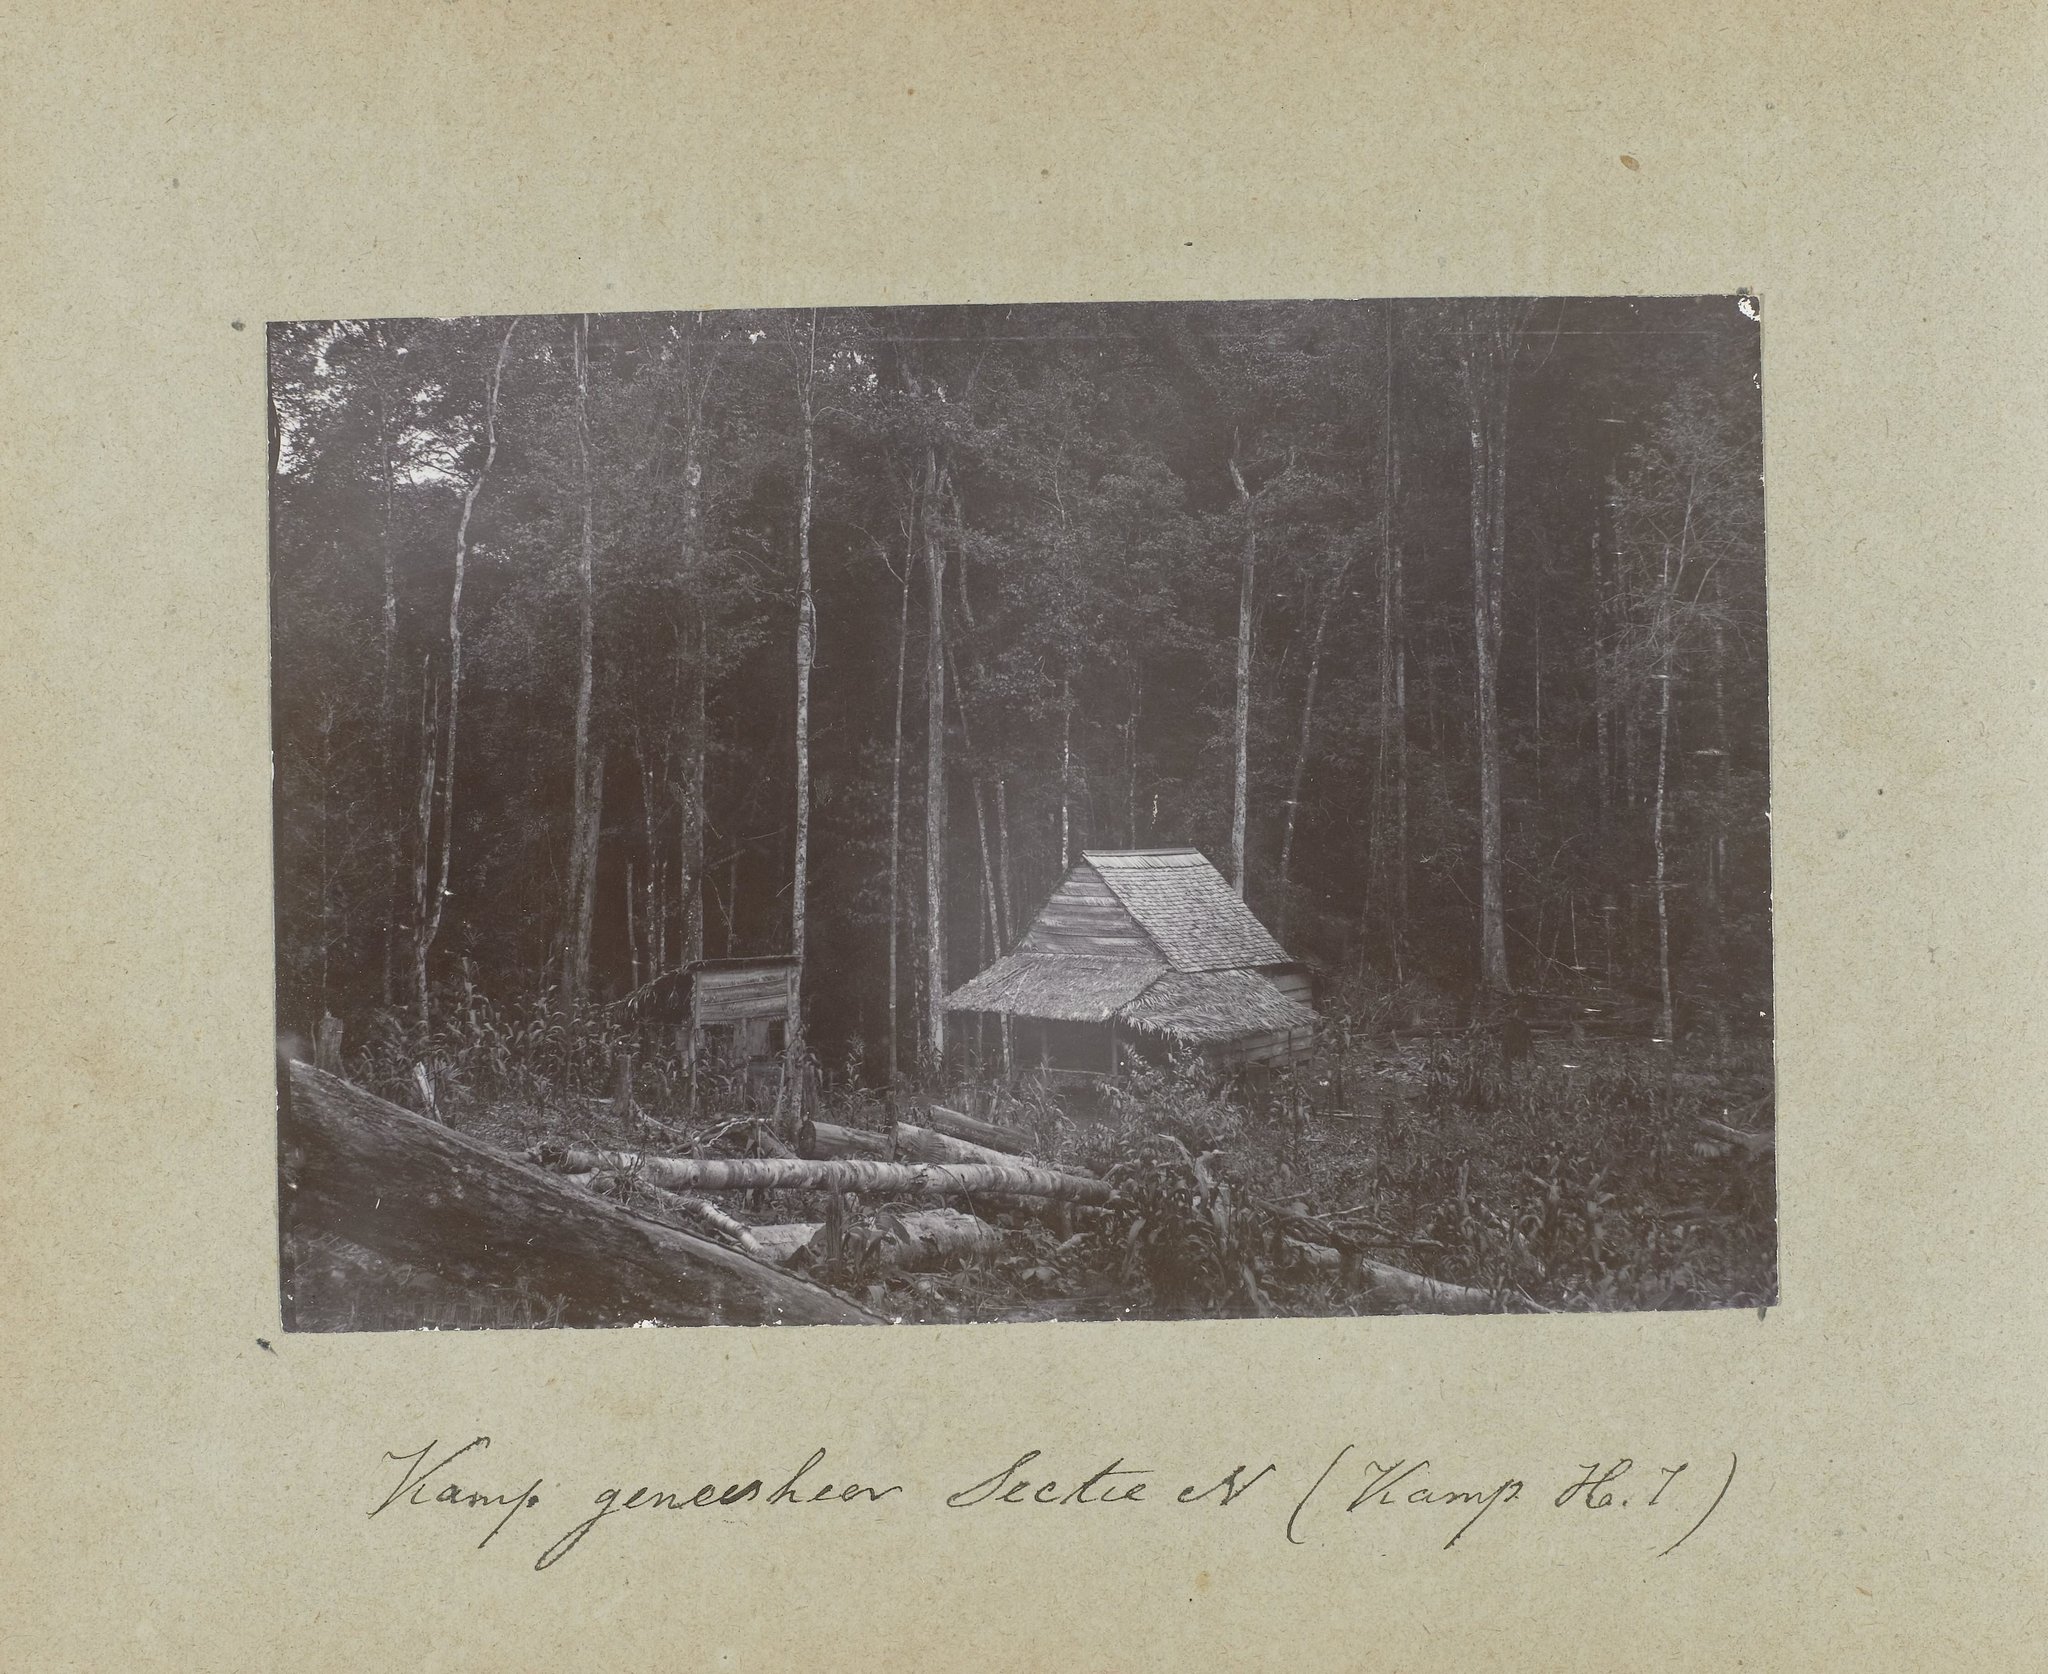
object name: photograph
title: Kamp geneesheer Sectie N (Kamp H.I.)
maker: augusta curiel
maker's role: fotograaf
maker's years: 1873-1937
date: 1905-1910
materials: photographic support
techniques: photography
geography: suriname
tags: jacob evert wesenhagen, railway, tramway; rack railway, suriname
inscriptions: inscription: ‘Kamp geneesheer Sectie N (Kamp H.I.)’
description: Het tijdelijke onderkomen van de geneesheer Jacob Evert Wesenhagen in sectie N. Foto in het fotoalbum over de aanleg van de Lawaspoorweg in Suriname in de jaren 1903-1912. Onderdeel van een groep objecten afkomstig van de familie Wesenhagen in Suriname.